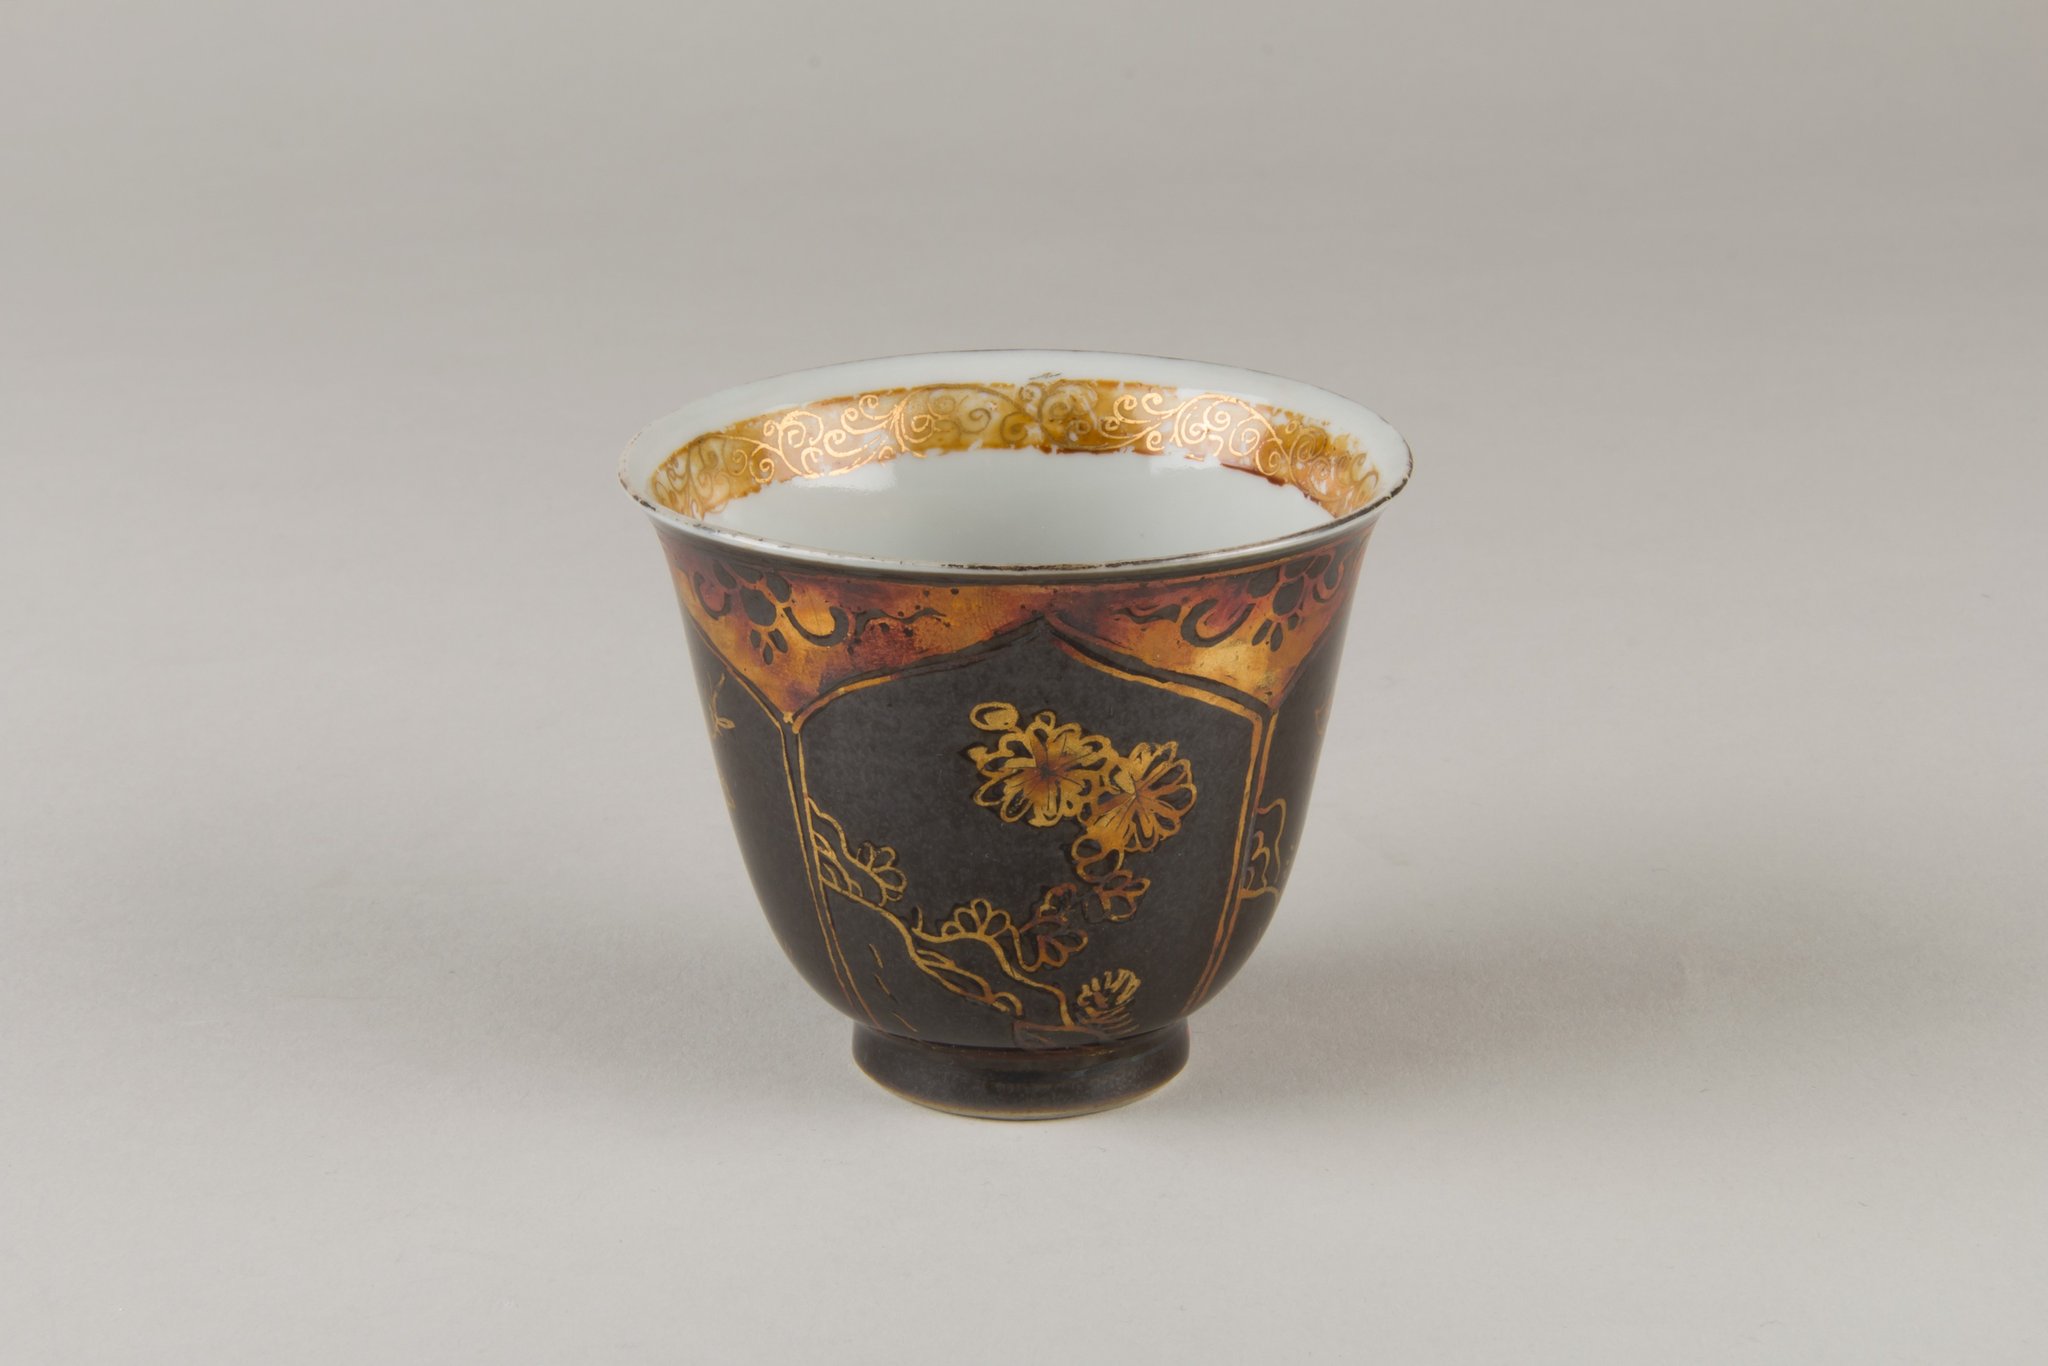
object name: cup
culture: chinese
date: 1736-1795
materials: gilt, glaze, porcelain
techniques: painting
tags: flowers